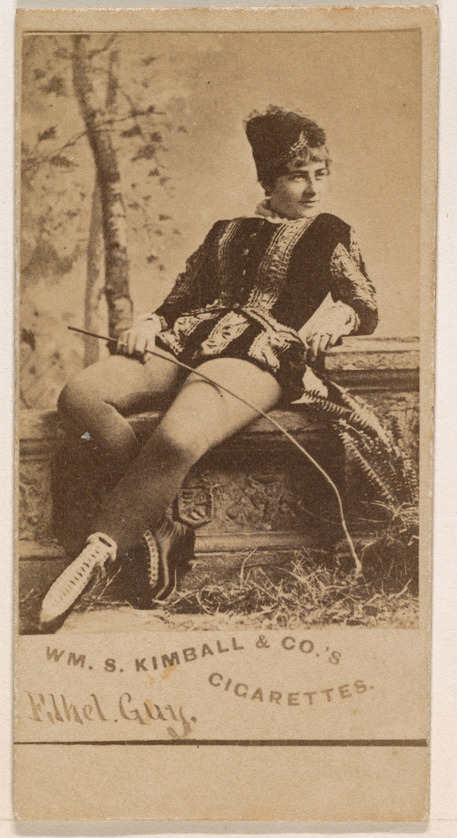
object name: photograph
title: Ethel Guy, from the Actresses series (N203) issued by Wm. S. Kimball & Co.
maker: william s. kimball & company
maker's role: publisher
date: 1889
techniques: color lithograph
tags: portraits,women,actresses